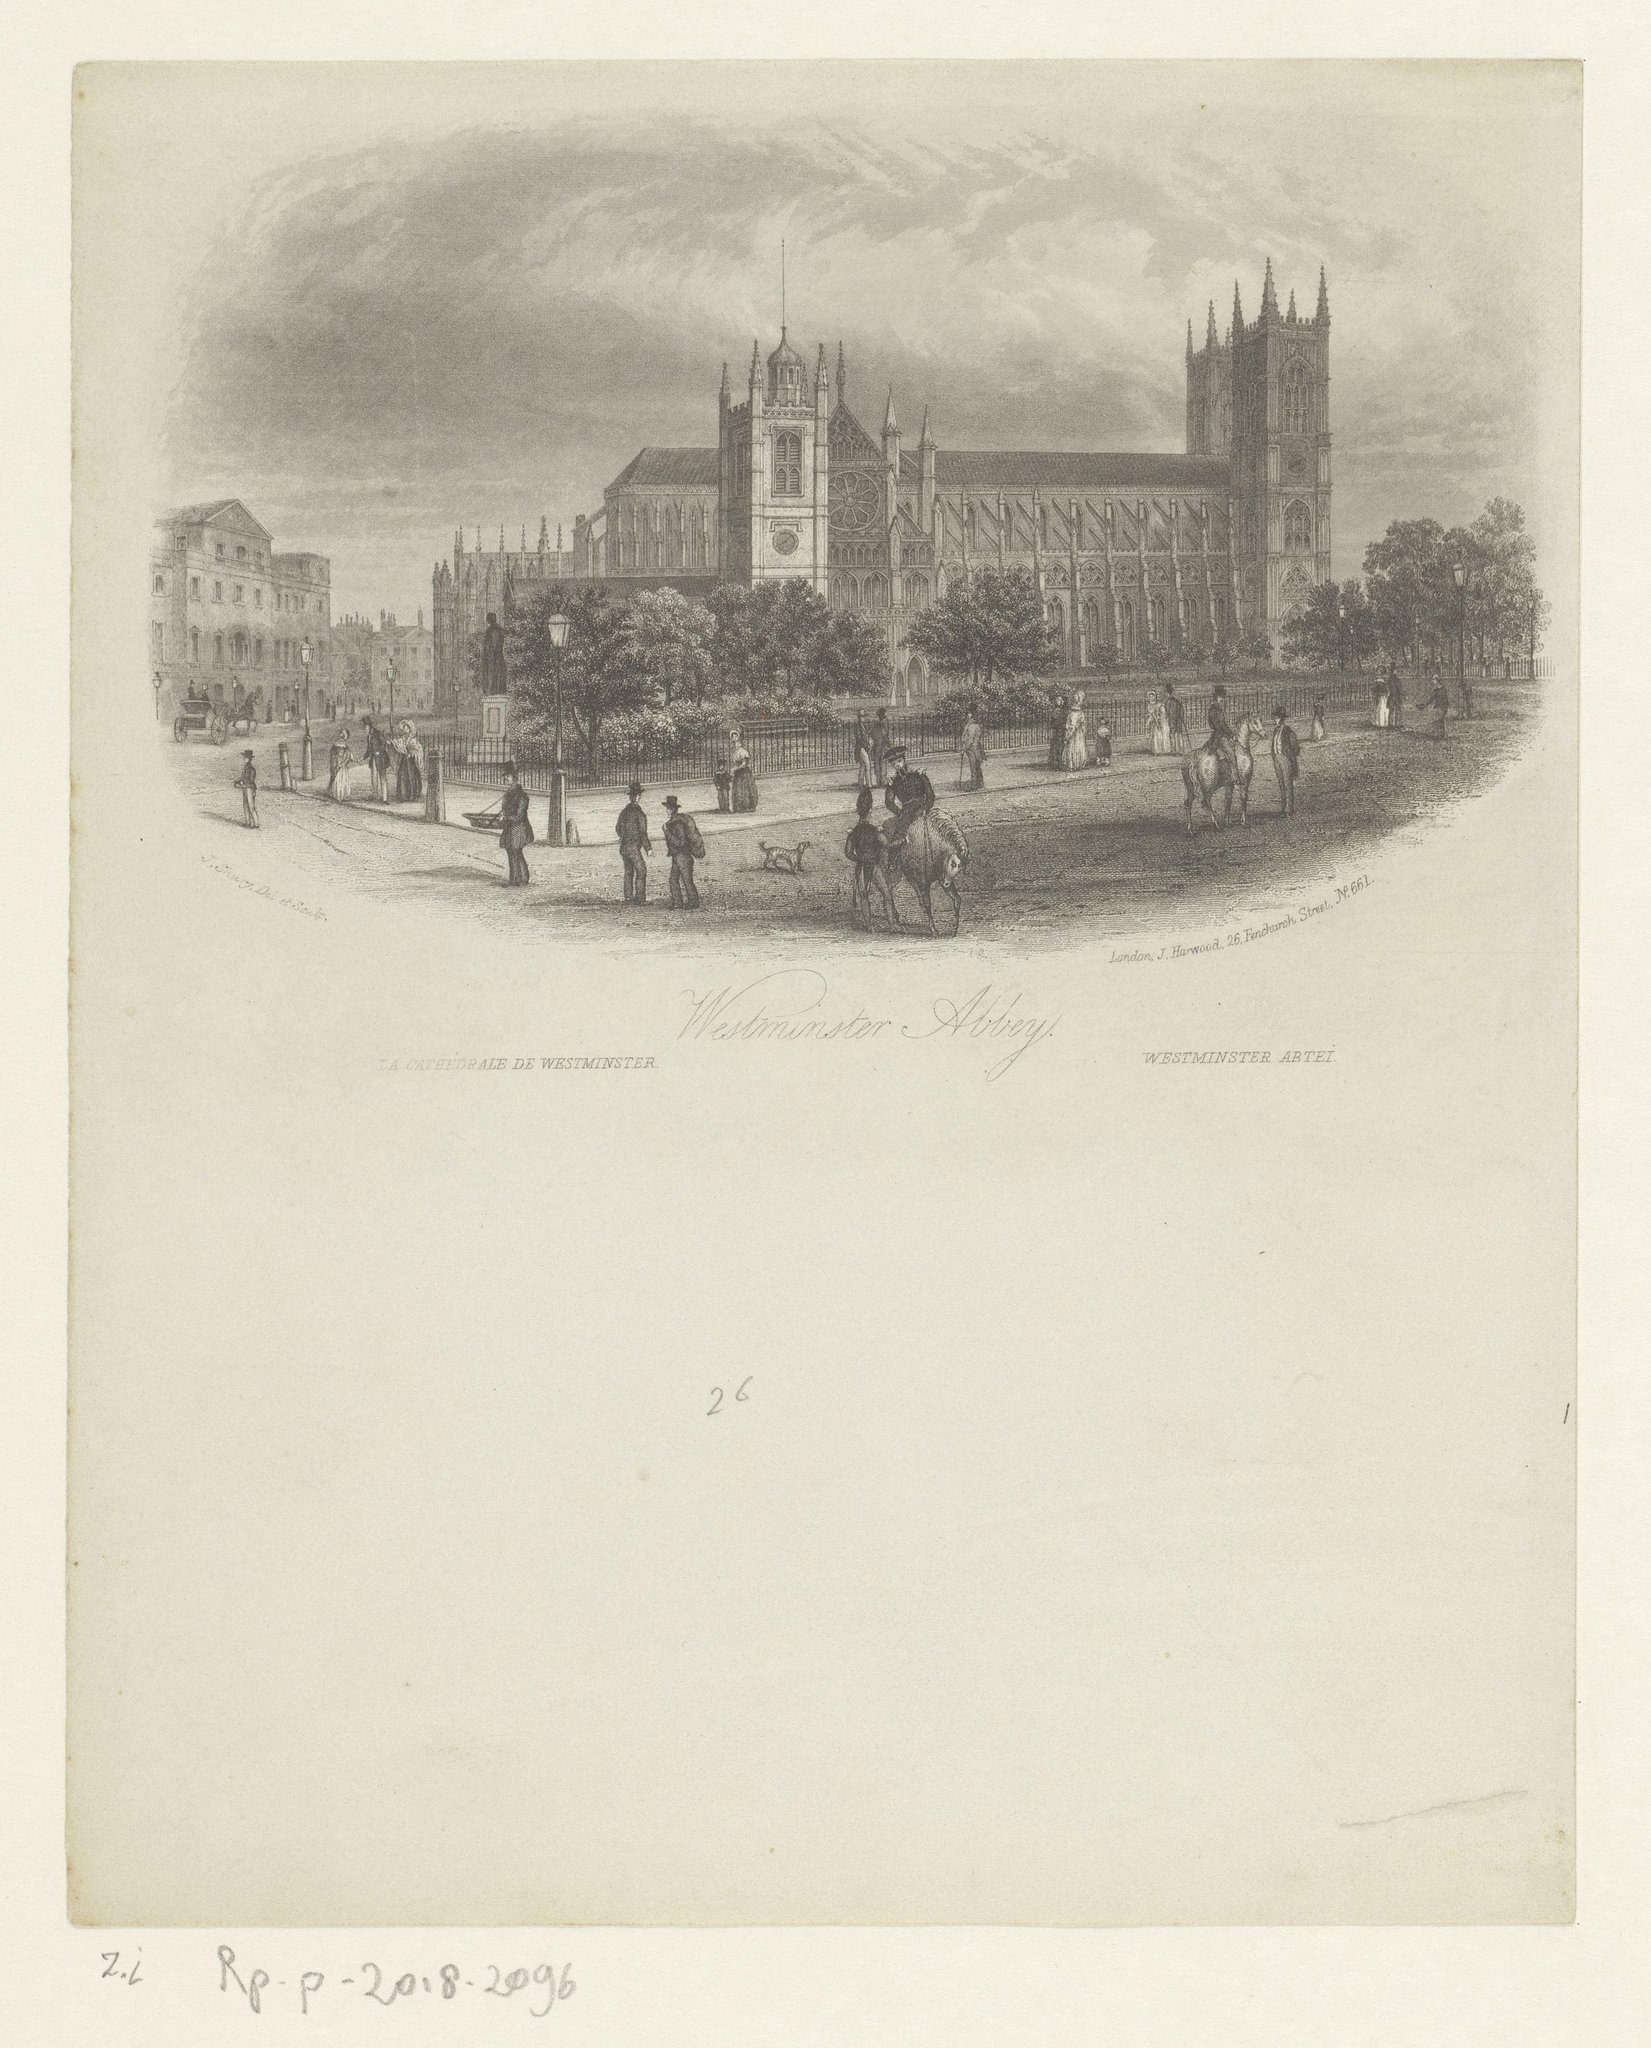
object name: print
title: La Cathédrale de Westminster / Westminster Abbey / Westminster Abtei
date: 1814-1844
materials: paper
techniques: engraving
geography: london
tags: church (exterior), westminster abbey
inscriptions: collector's mark: Lugt 2228